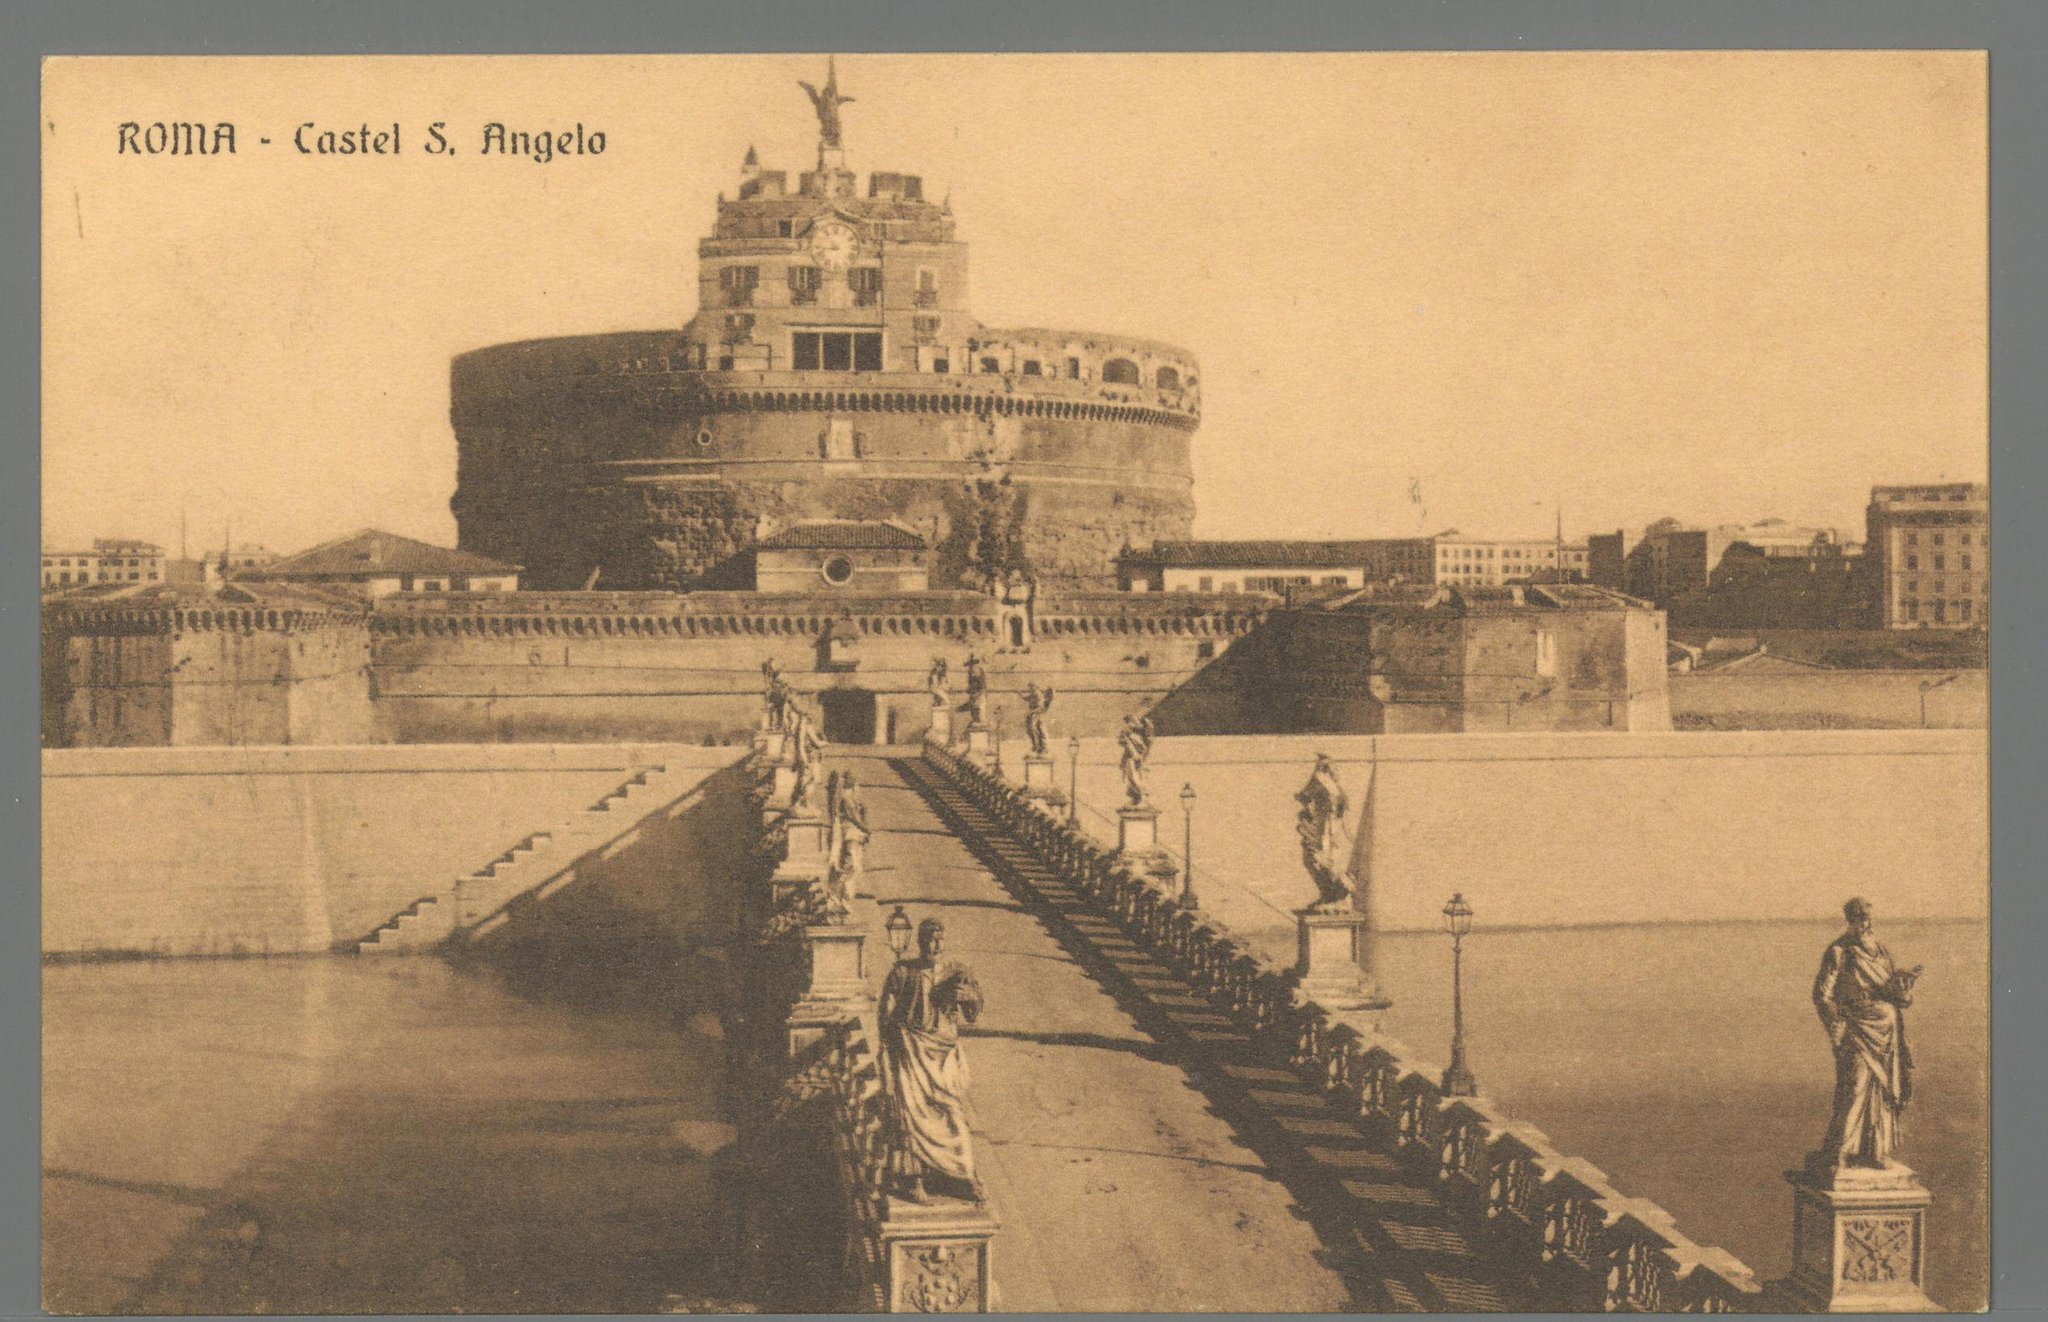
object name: ansichtkaart, prentbriefkaart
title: Roma. Castel S. Angelo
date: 1906-1920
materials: cardboard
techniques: photograph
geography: italy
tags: fortress, river, bridge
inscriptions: mark: ‘C.A.R.’